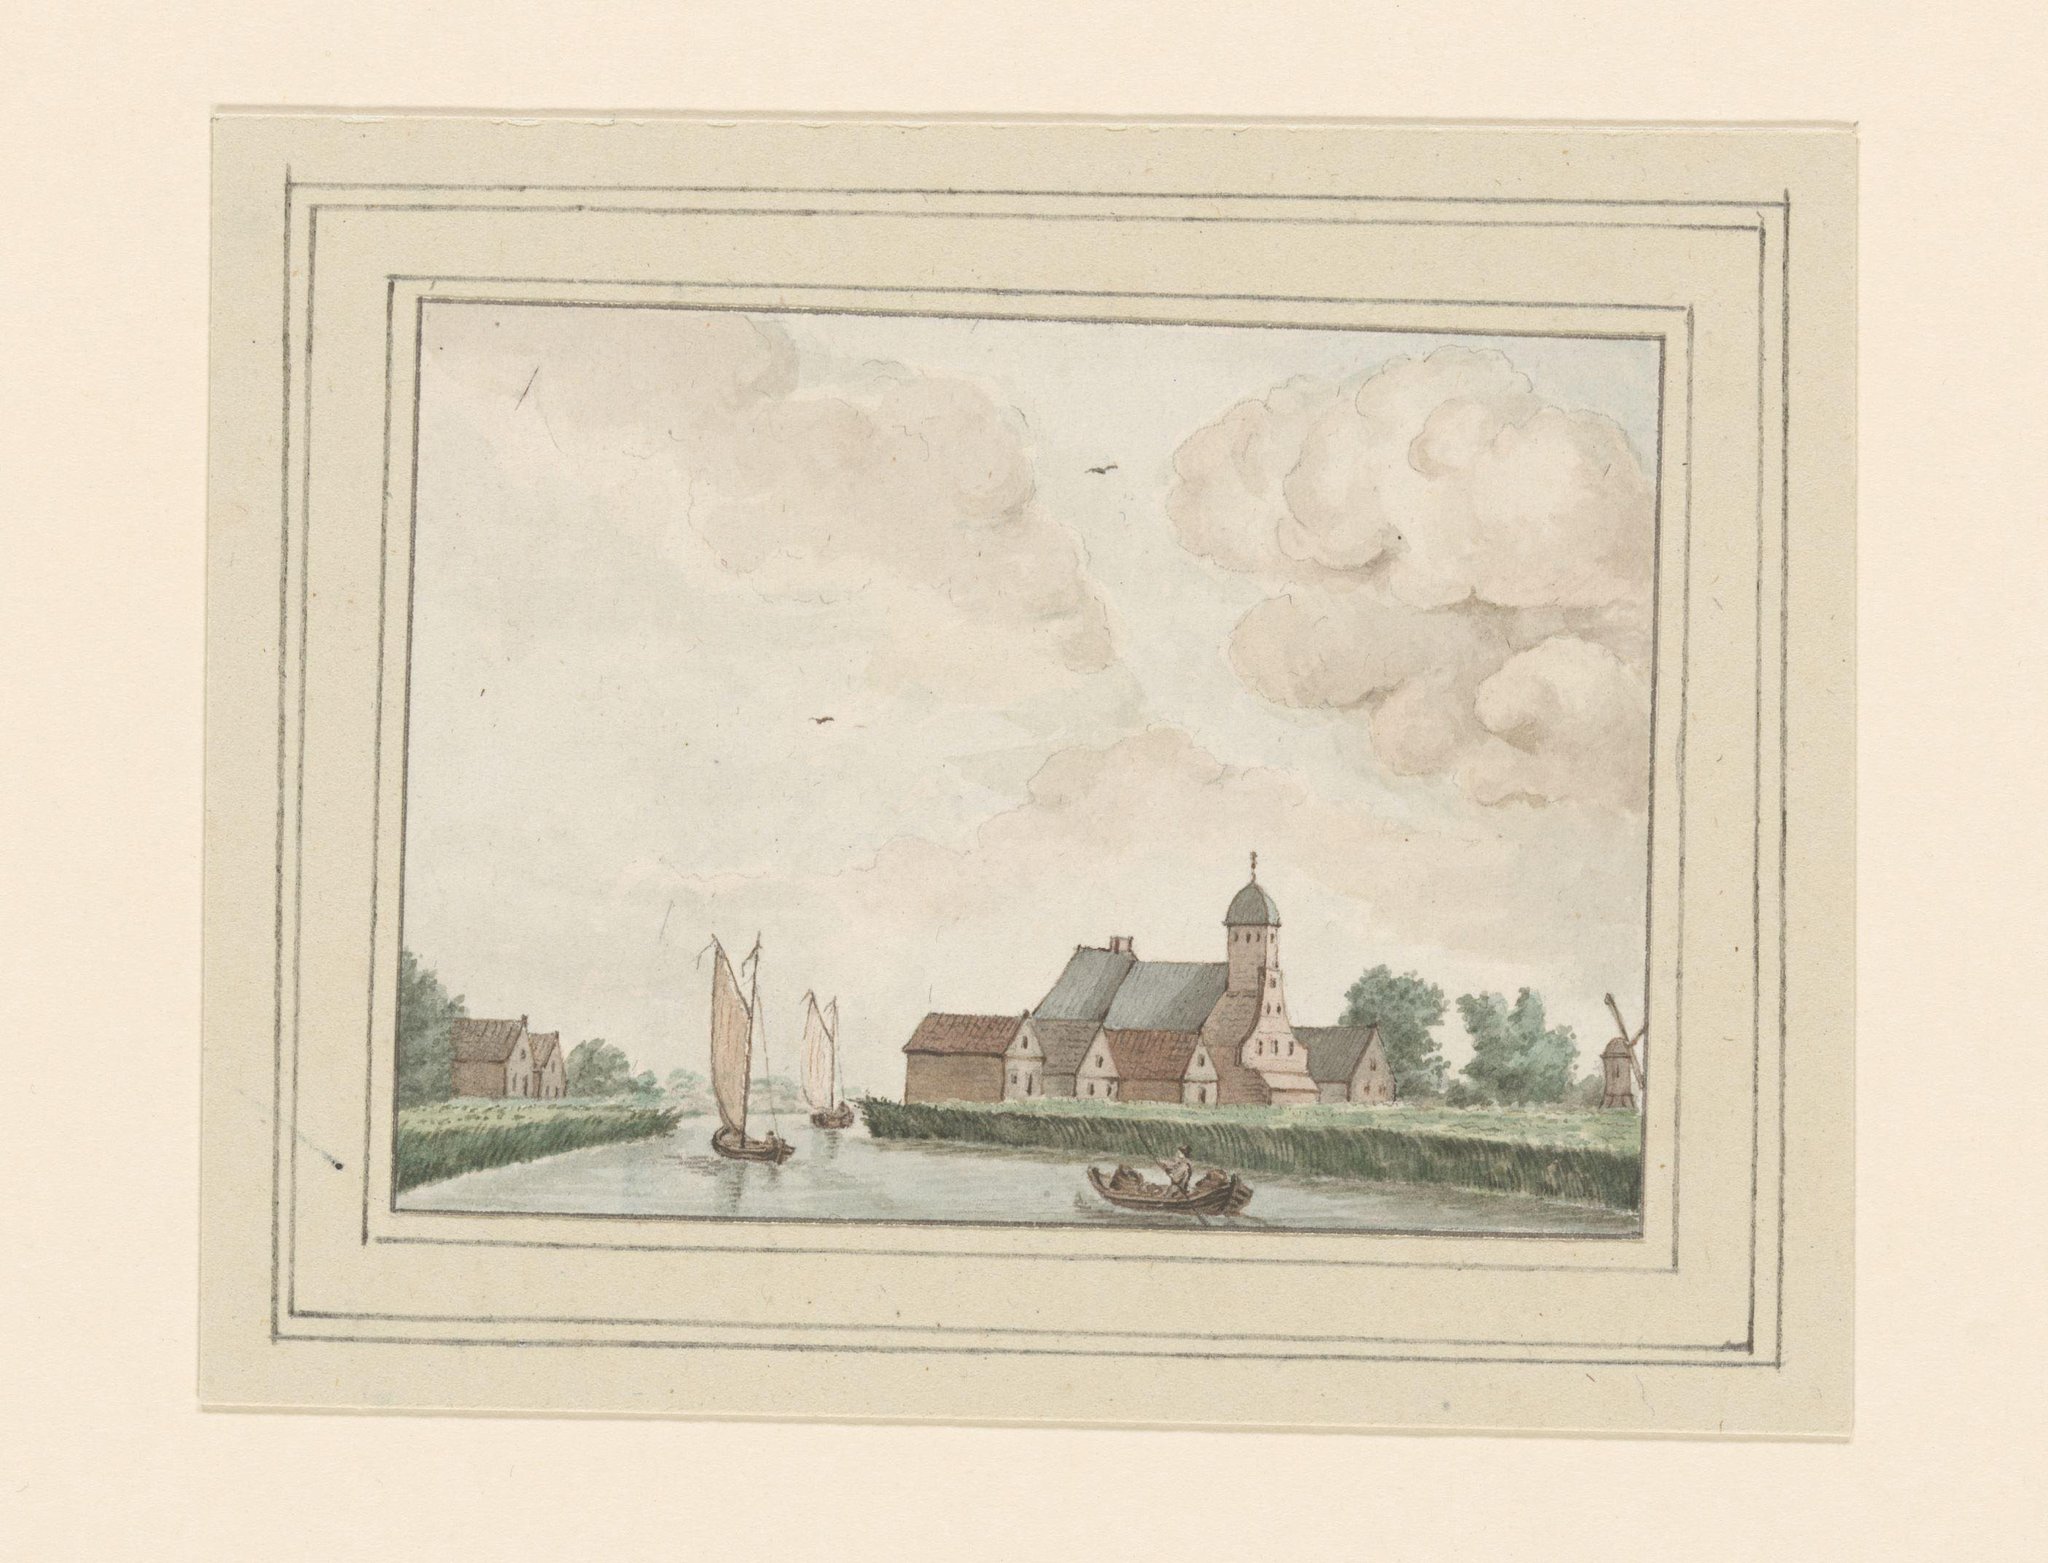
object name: drawing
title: Gezicht op het dorp Koedijk aan het Noordhollandsch Kanaal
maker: Anonymous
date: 1700-1799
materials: paper, pencil, watercolor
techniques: aquarelle, drawing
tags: canals, waters (in village), church (exterior), windmill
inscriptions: annotation: ‘'t dorp Koedijk’